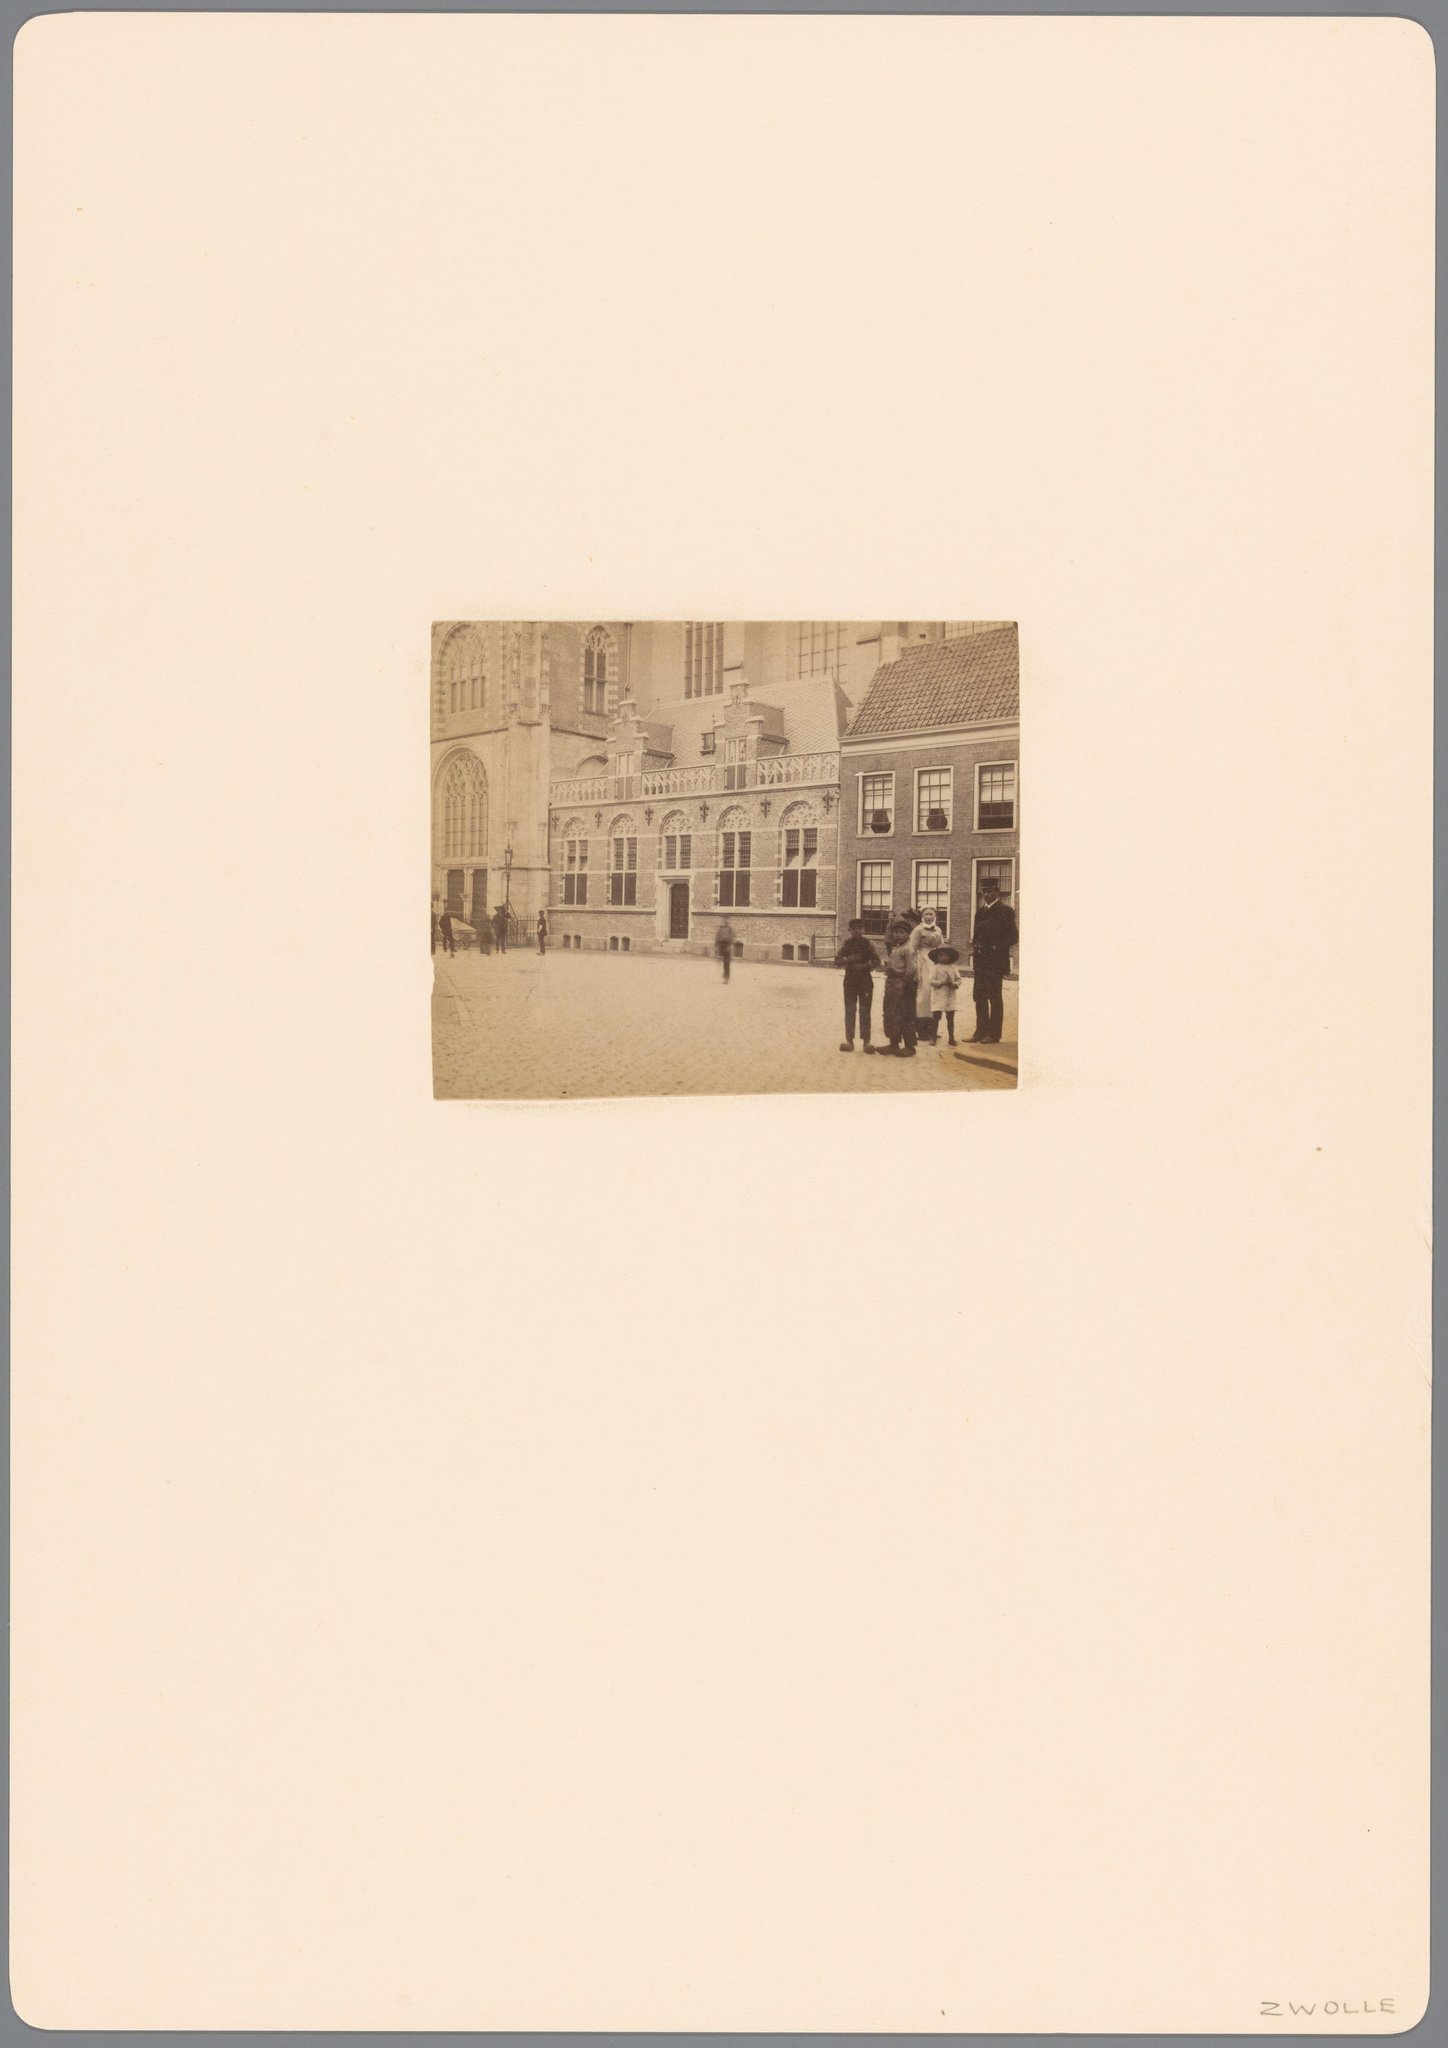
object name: photograph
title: Catechisatielokaal van de Grote of Sint-Michaëlskerk te Zwolle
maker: Anonymous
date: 1860-1900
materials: cardboard, photographic support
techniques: albumen print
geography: zwolle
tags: church (exterior)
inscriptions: annotation: ‘Zwolle’